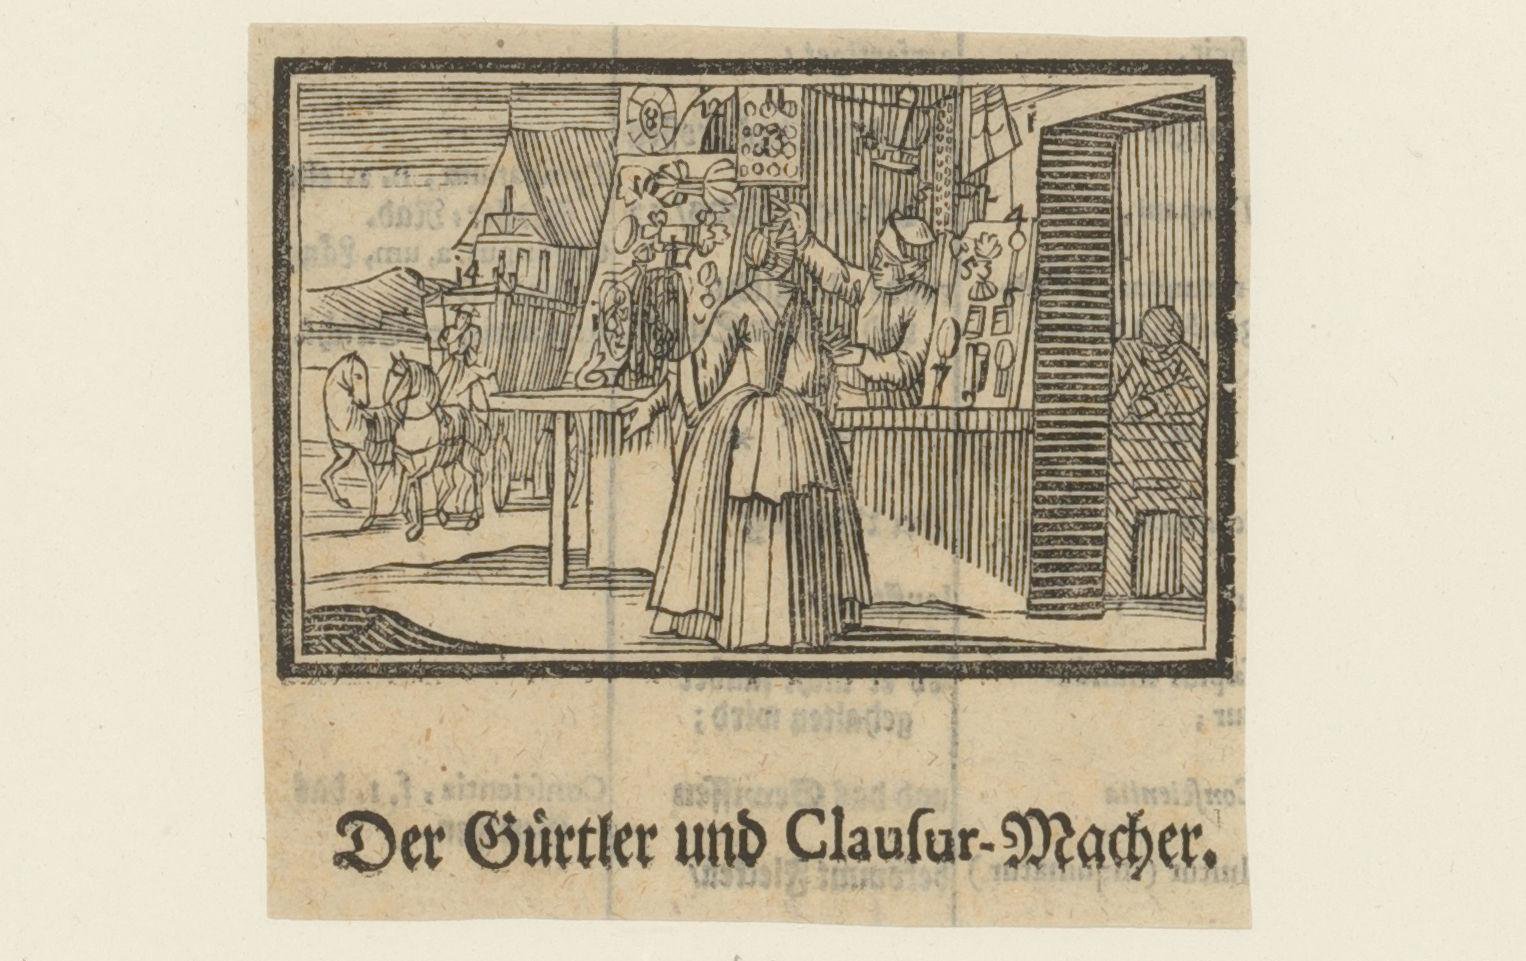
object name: print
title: Der Gurtler und Clausur-Macher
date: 1719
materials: paper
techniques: letterpress printing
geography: nuremberg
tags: handicrafts, craftsman at work, belt, girdle, waistband, key, textile fabric, cloth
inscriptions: collector's mark: Lugt 1641, stamp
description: Prent uit: Comenius, Johannes Amosius. Orbis sensualium picti pars prima (...). Neurenberg: Martin Endter, 1719, dl. 2, p. 122. Prent eerder gebruikt in: Comenius, Johannes Amosius. Orbis Sensualium Picti denuo aucti Pars Secunda (...). Neurenberg: Martin Endter, 1730, dl. 2.